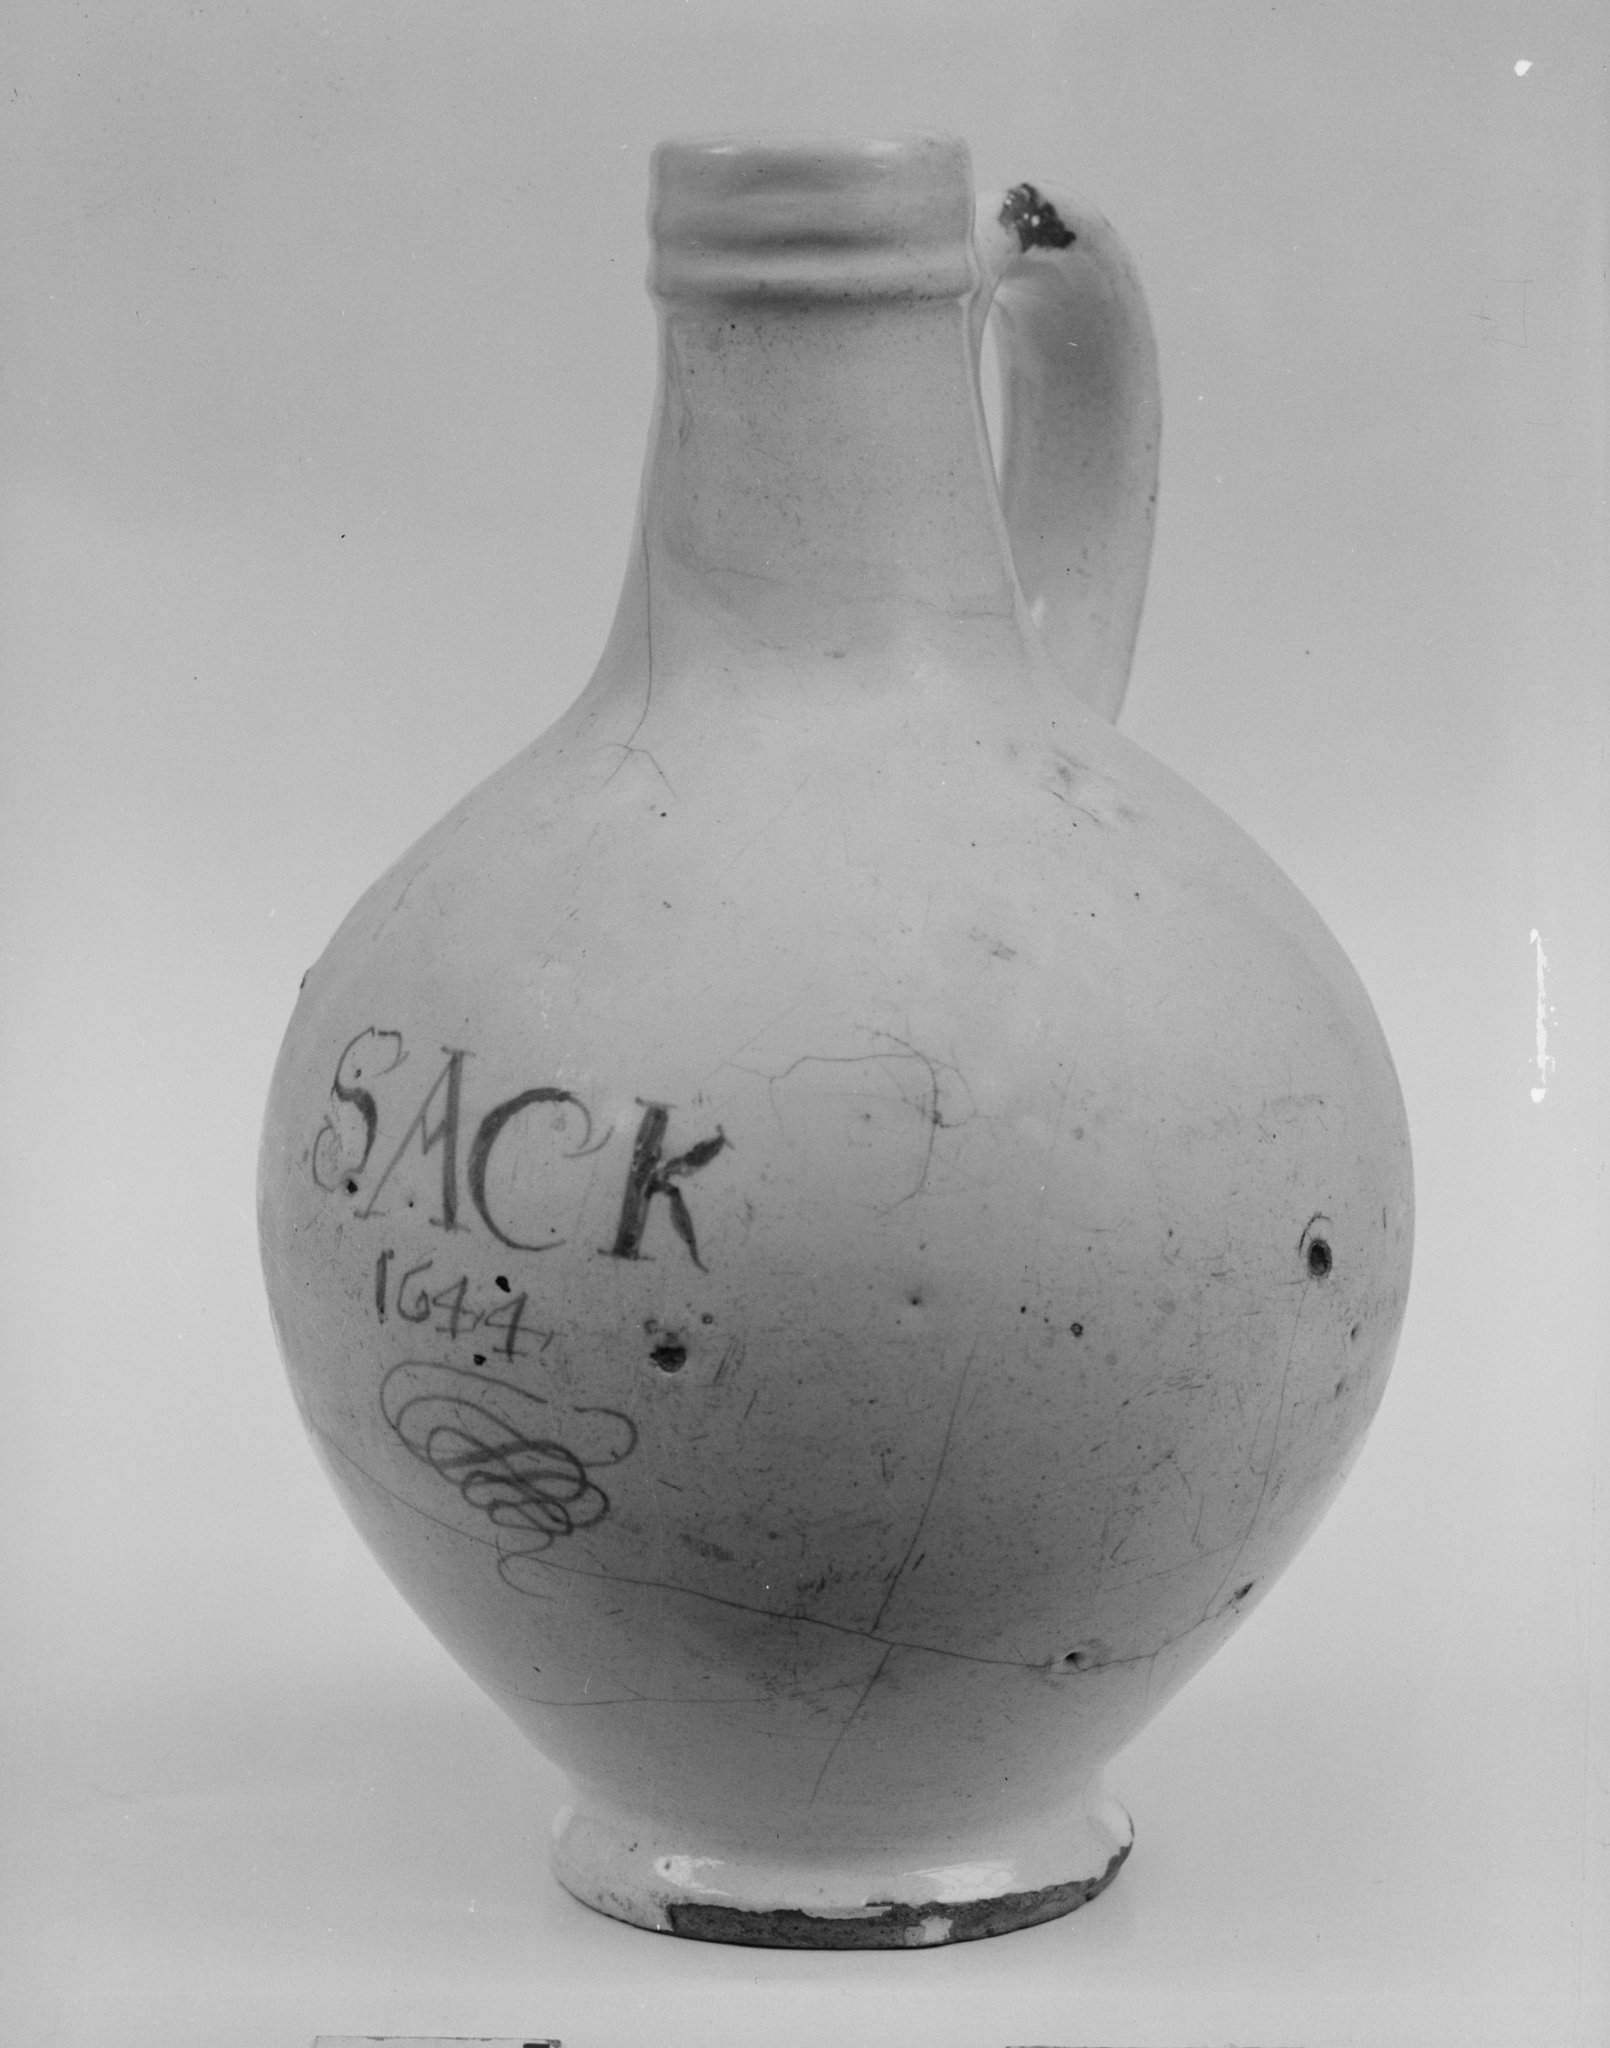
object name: sack bottle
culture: british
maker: lambeth factories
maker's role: maker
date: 1644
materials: earthenware, tin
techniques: enamel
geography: england